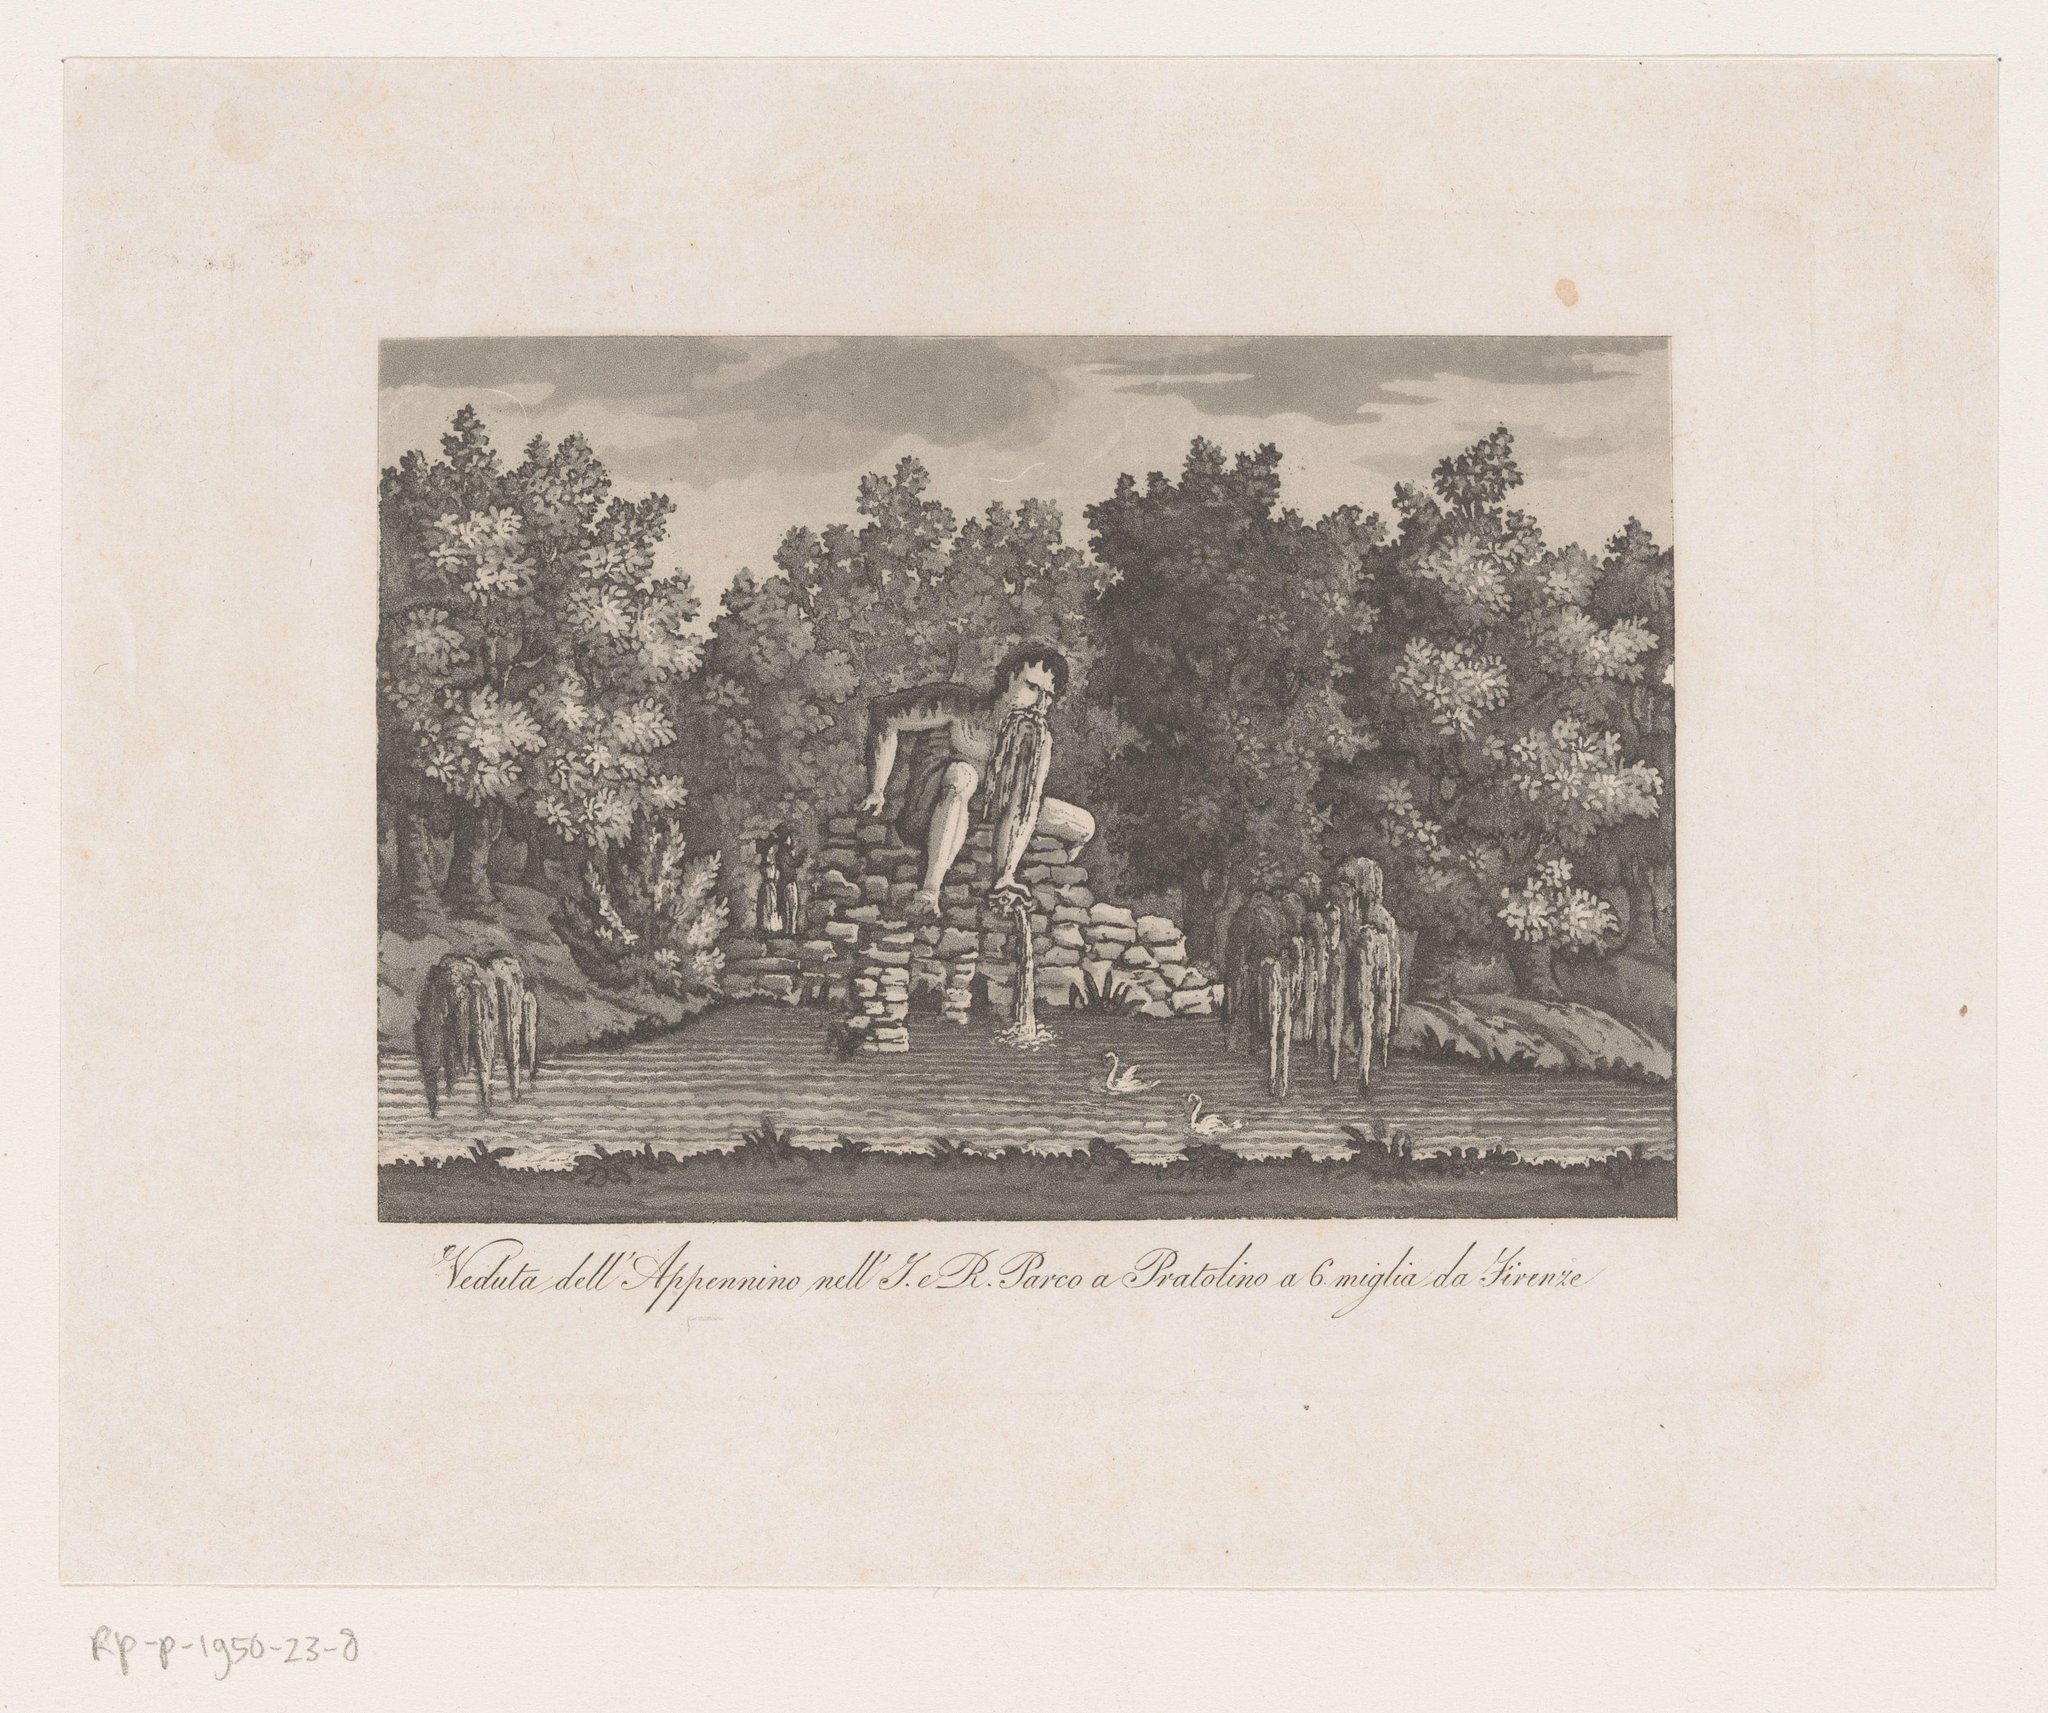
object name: print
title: Gezicht op een fontein in het Pratolino park bij Florence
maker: giuseppe molini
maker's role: bookseller, publisher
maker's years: 1772-1856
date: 1790-1856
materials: paper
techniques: aquatint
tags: park, garden fountain, ornamental fountain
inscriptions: collector's mark: Lugt 2228